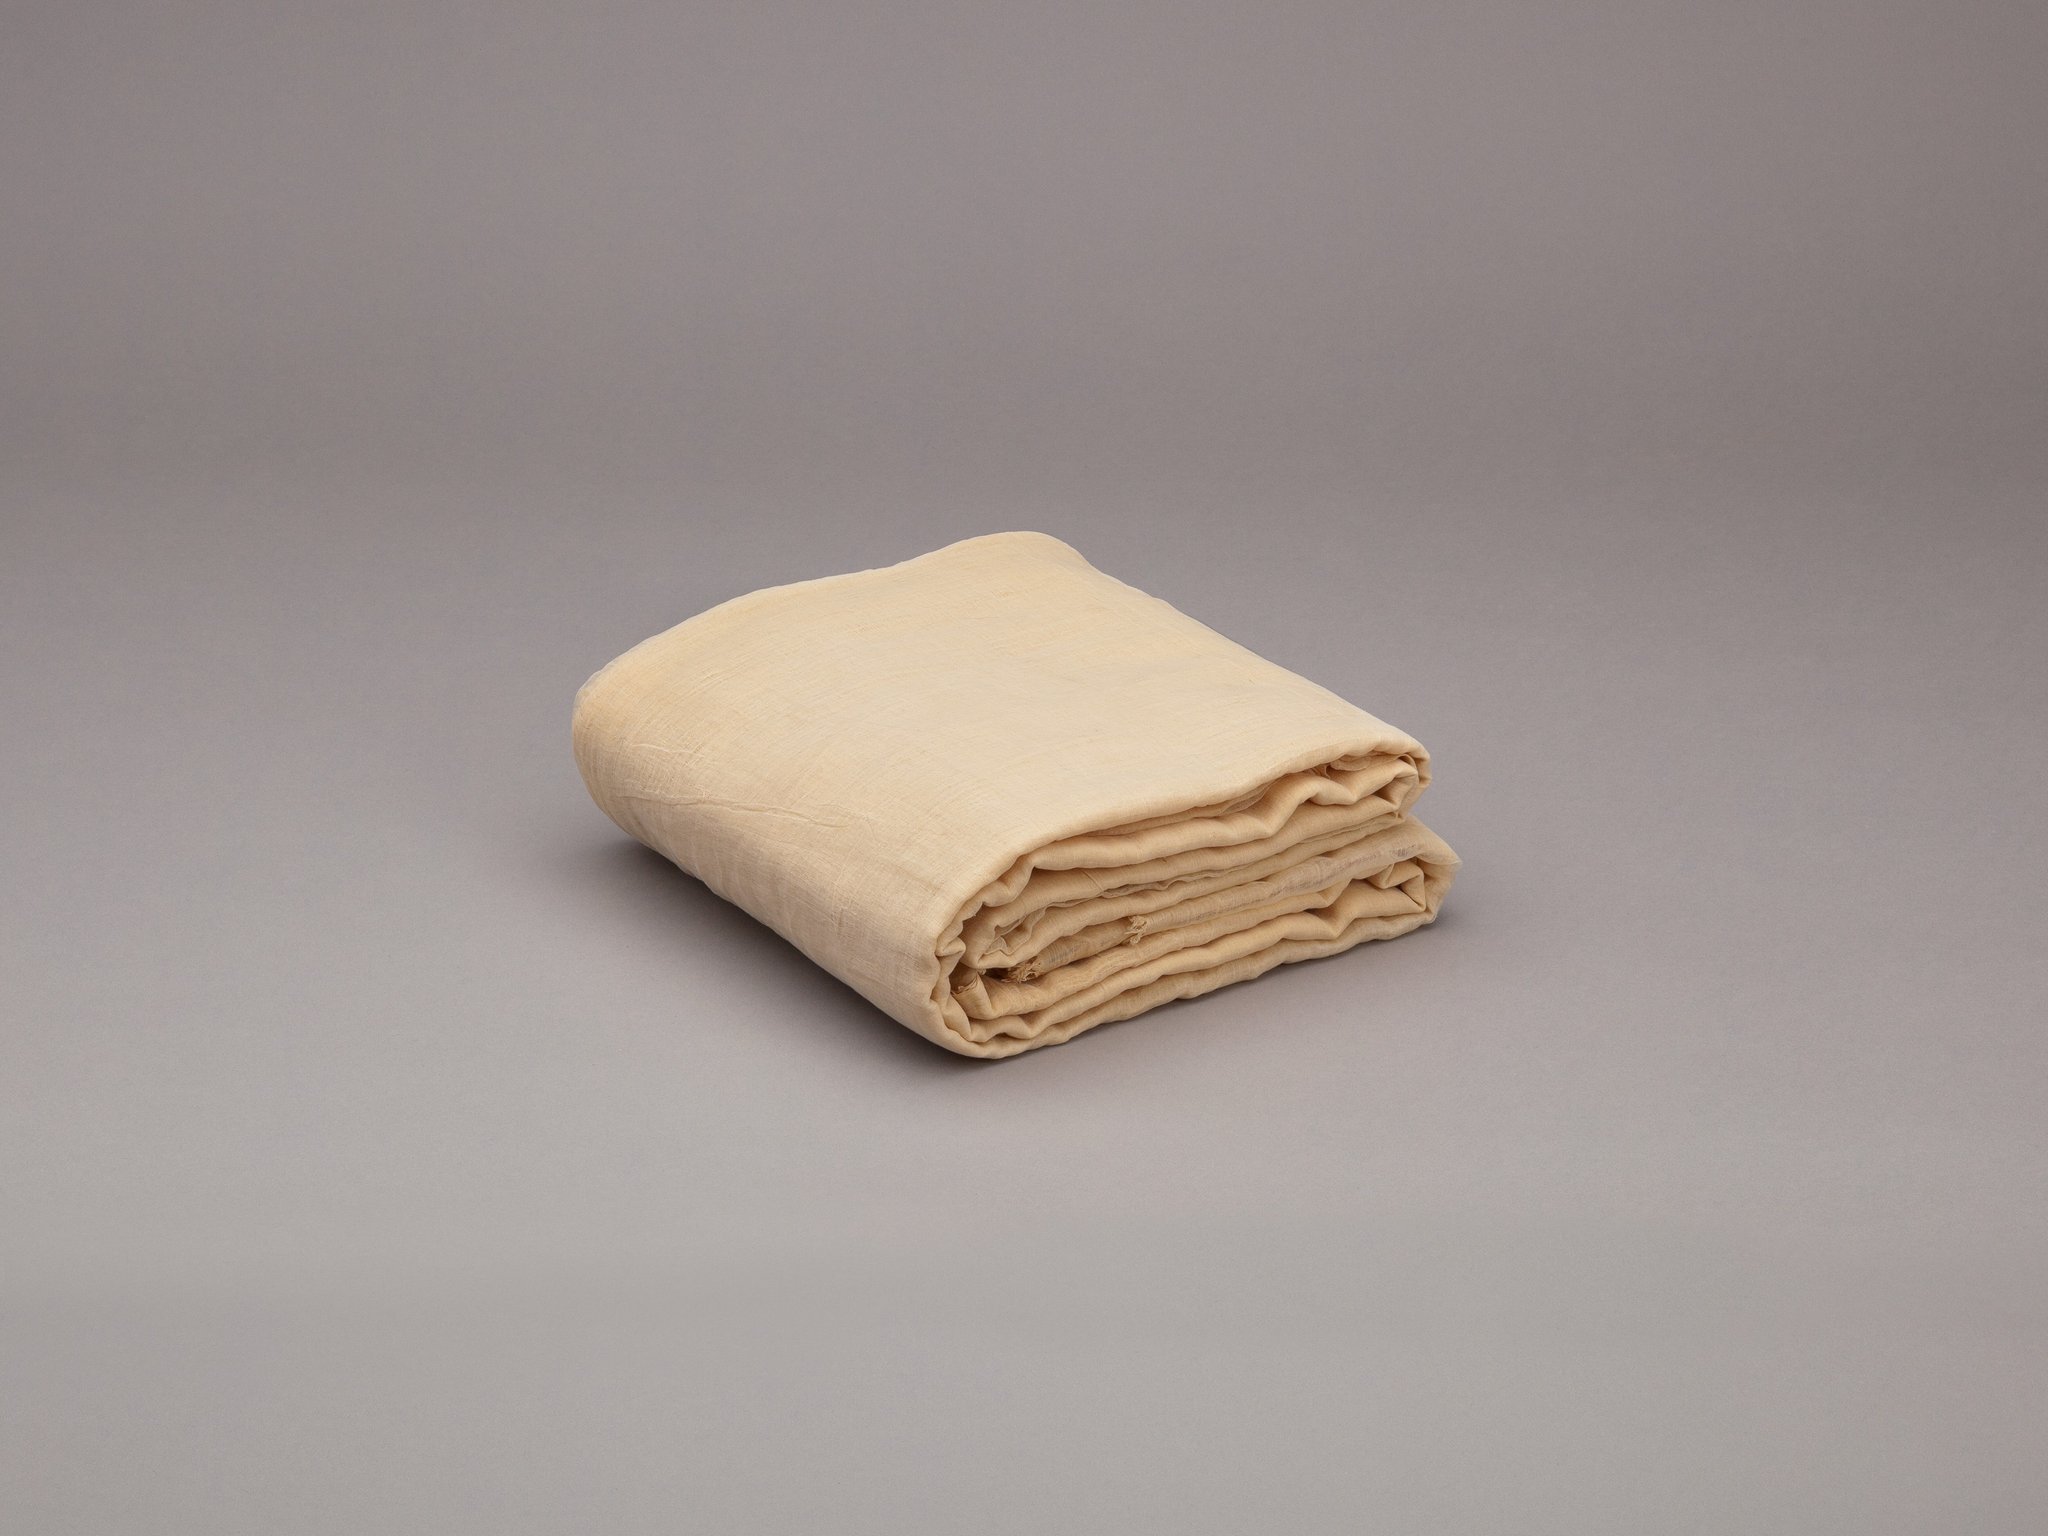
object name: sheet, weaver mark, sheer, very fine spin, very fine weave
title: Length of Very Sheer Linen Cloth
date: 1492-1473 BCE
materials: linen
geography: egypt